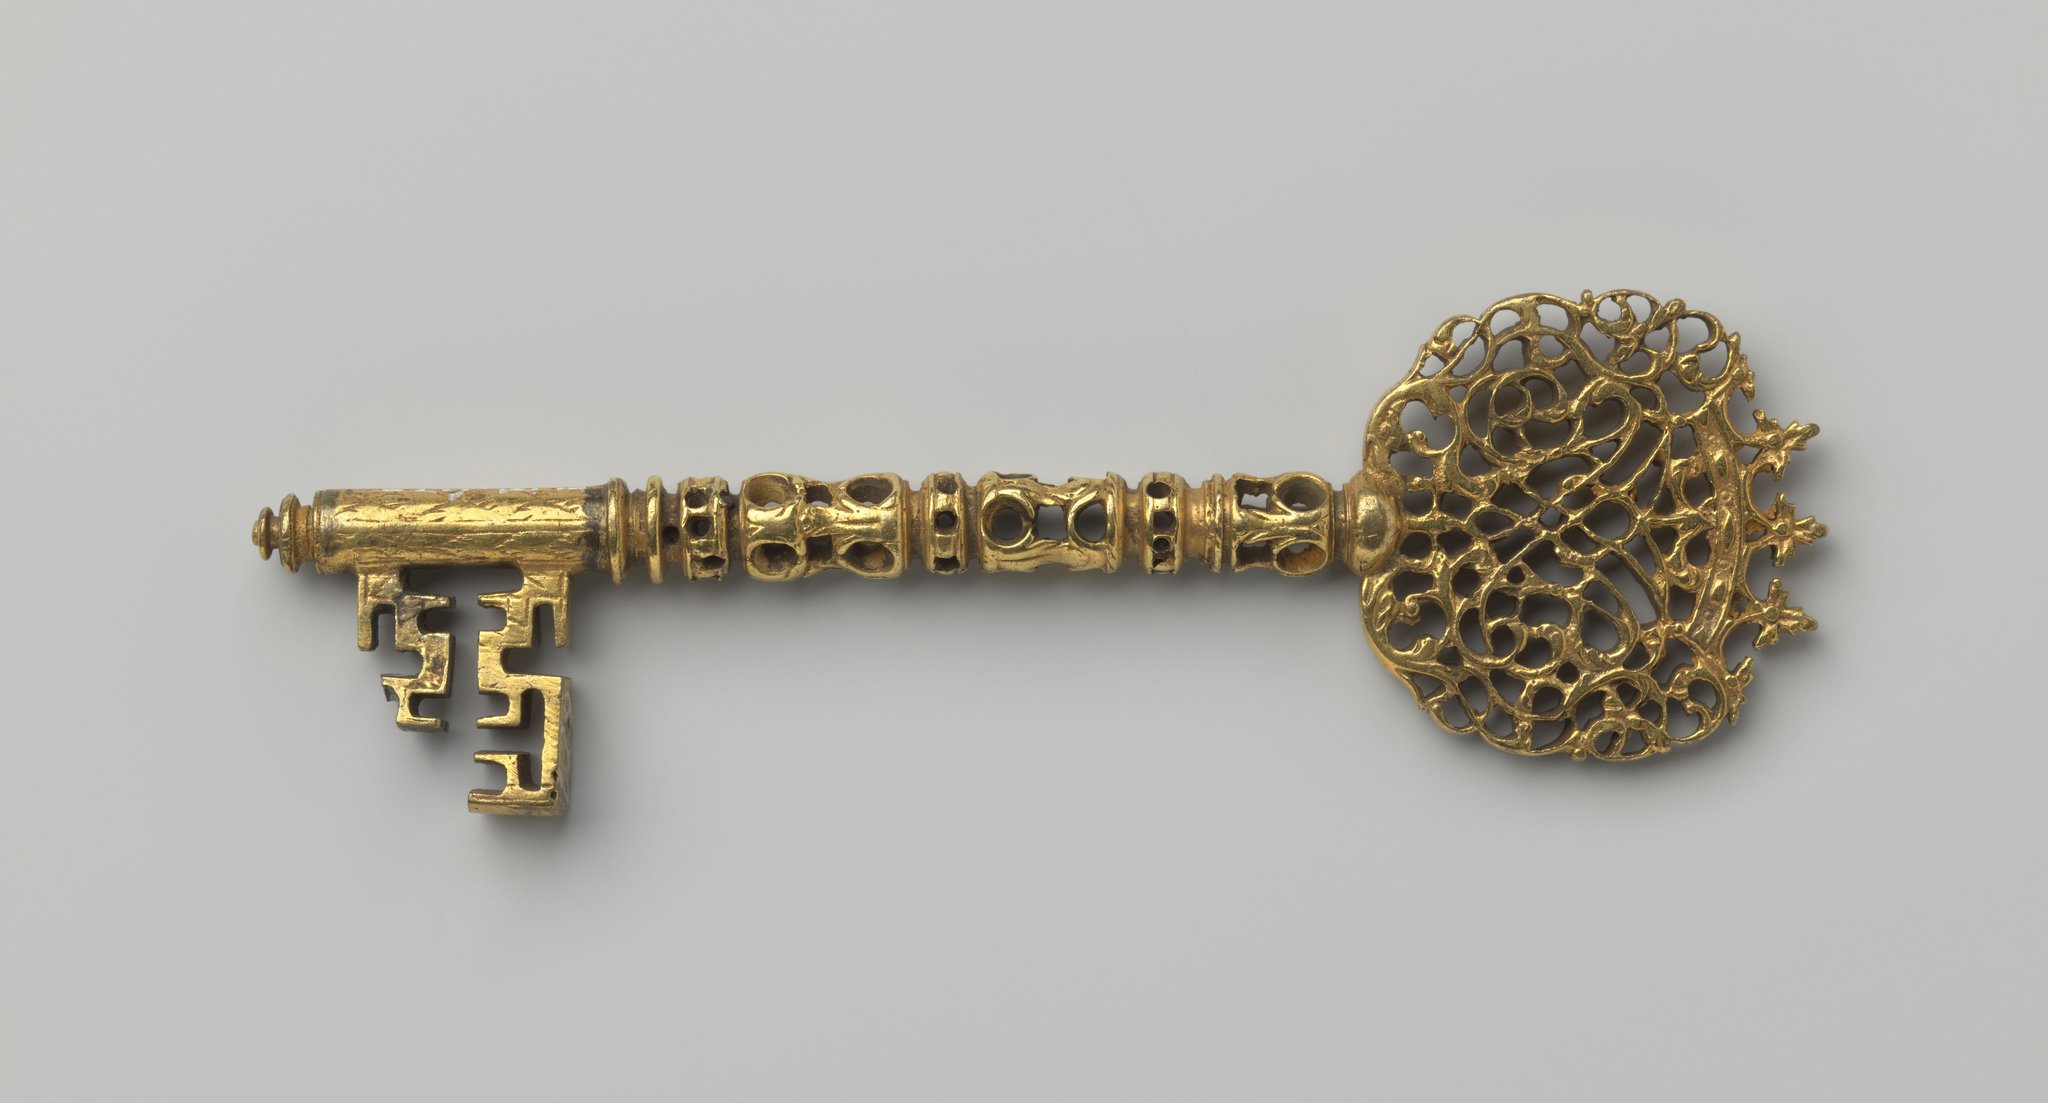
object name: key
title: Sleutel met dubbelmonogram JM en een markiezenkroon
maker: john wilkes (slotenmaker)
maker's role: slotenmaker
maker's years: -1733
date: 1675-1700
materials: iron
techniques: casting, gilding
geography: birmingham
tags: william i of the netherlands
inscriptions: monogram: ‘JM’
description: De ijzeren pin- of doorgaande sleutels (BK-NM-678/79) zijn uit dezelfde vorm gegoten. NM-679 is verguld en heeft een baard, die gedeeltelijk is afgebroken. De fraai uitgewerkte sleutelbaard past op de kruis- en reepbezetting van het slot, de steel is opengewerkt, het sleuteloog heeft de vorm van van een door rankenwerk omgeven dubbelmonogram JM met een markiezenkroon (vijf fleurons).